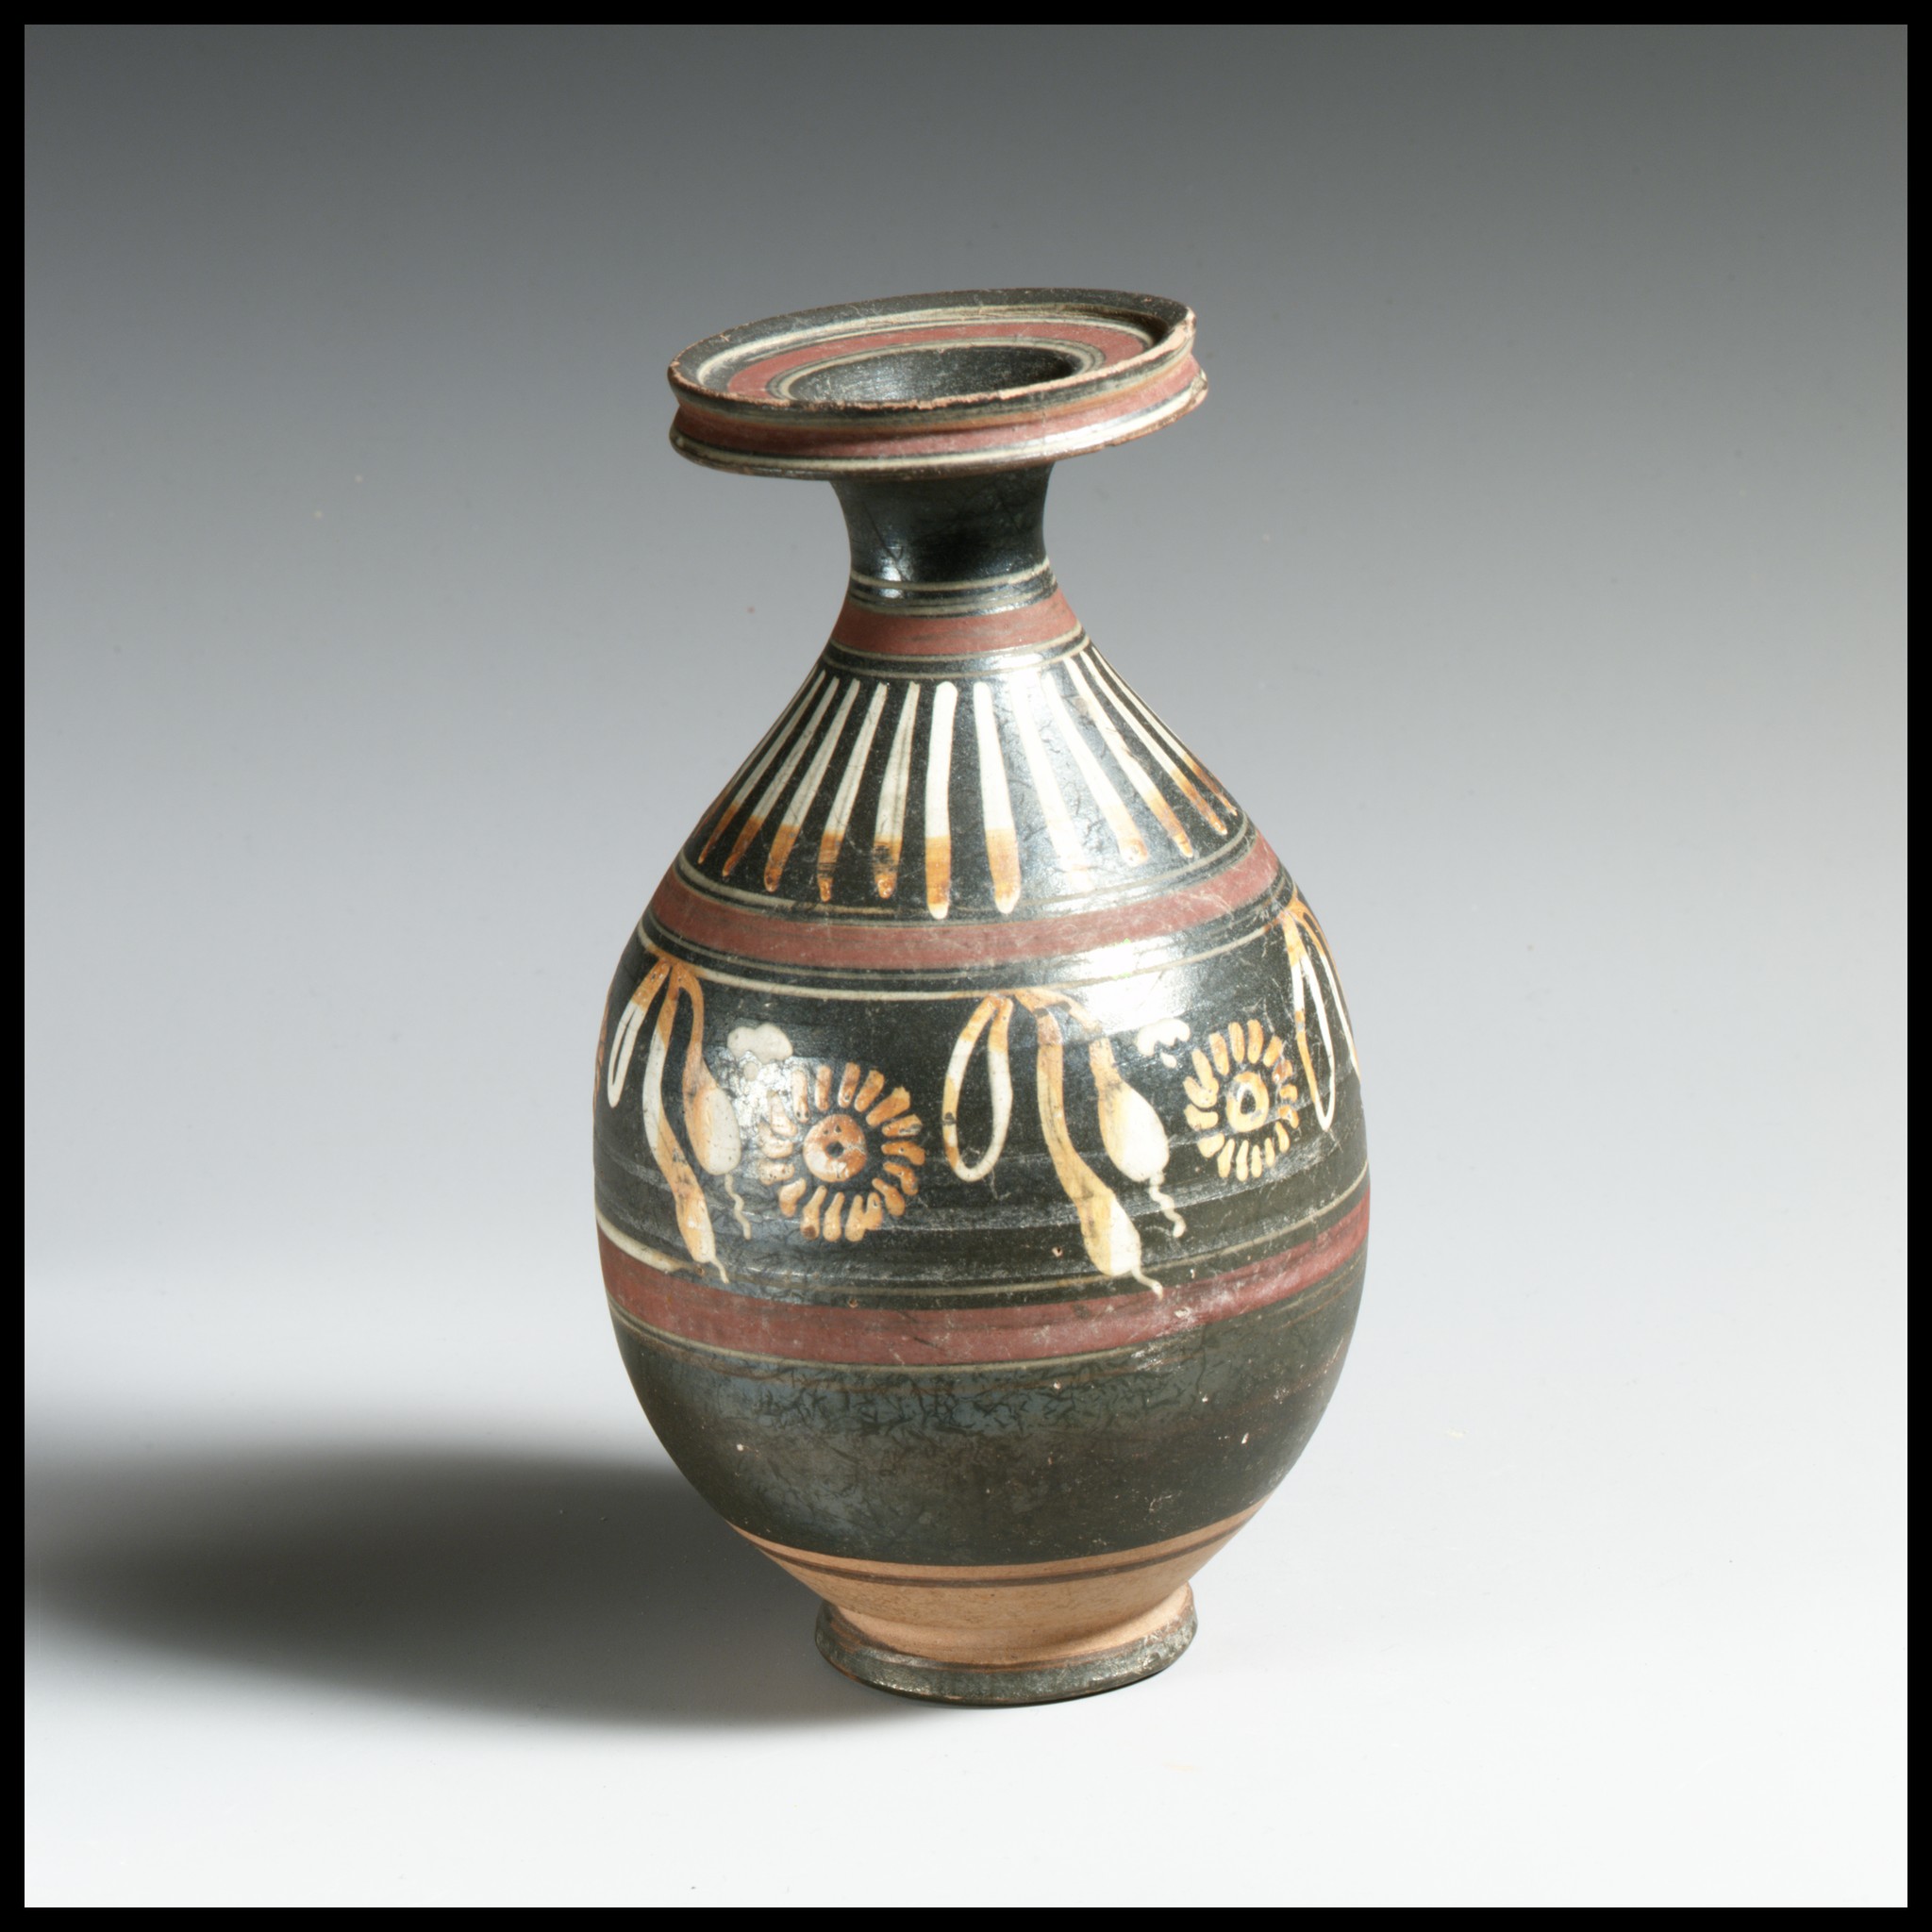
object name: bottle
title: Terracotta bottle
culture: greek, south italian, apulian, gnathian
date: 334-268 BCE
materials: terracotta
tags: flowers